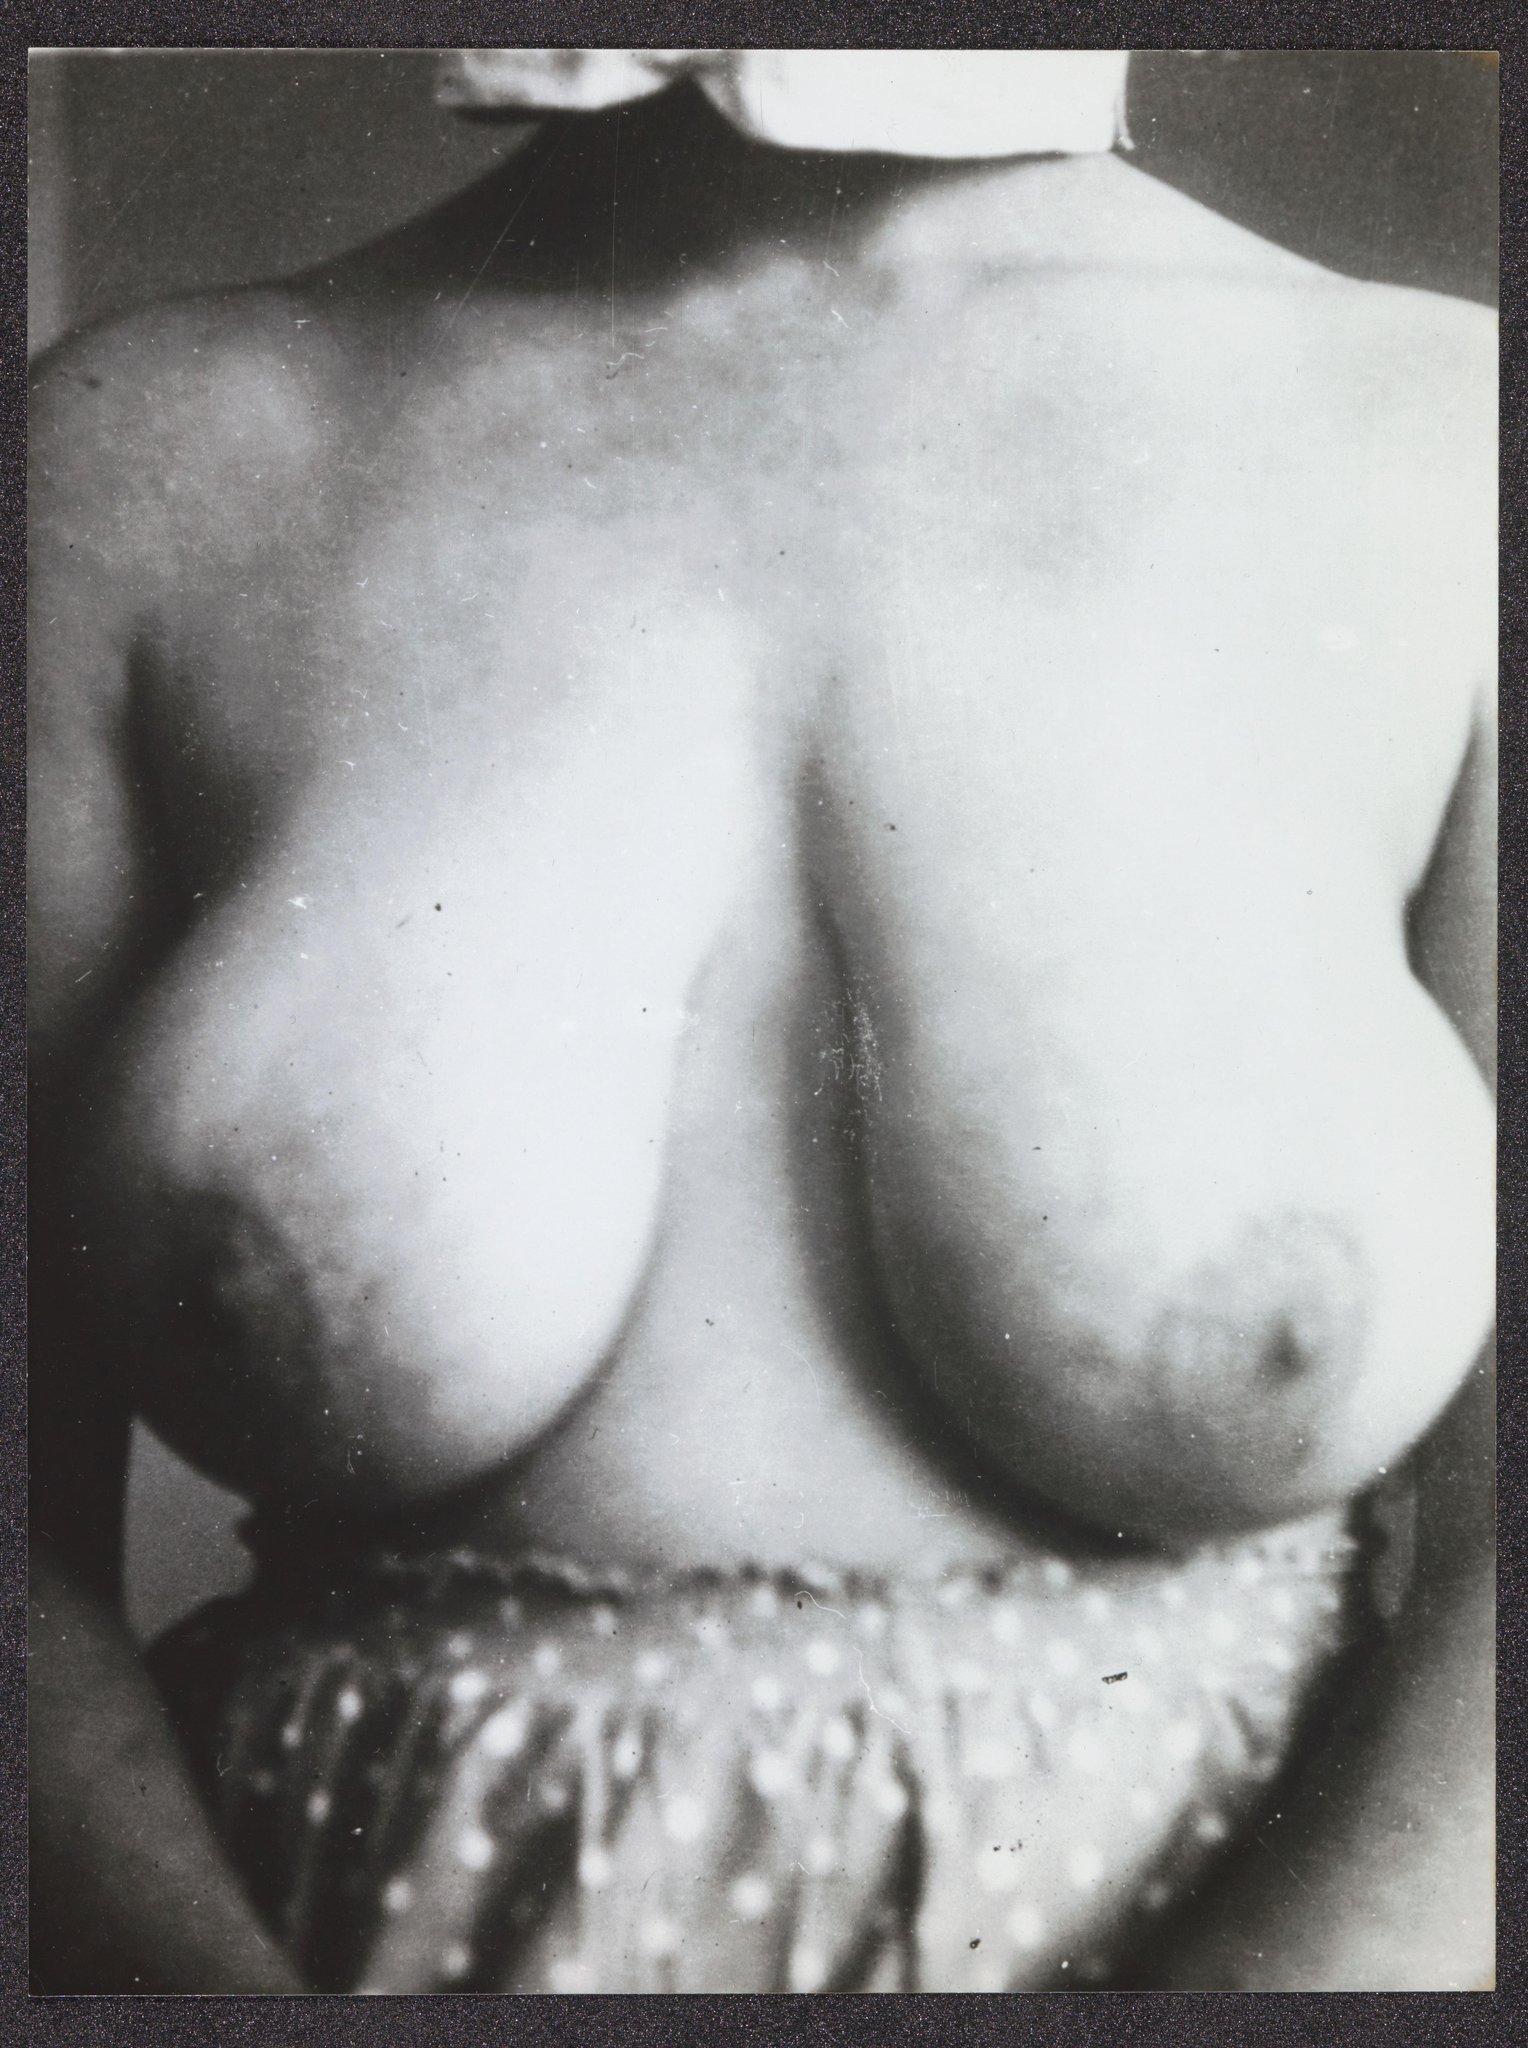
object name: photograph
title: Buste van een vrouw na een chirurgische ingreep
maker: Anonymous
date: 1930-1964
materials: paper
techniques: gelatin silver print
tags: breasts